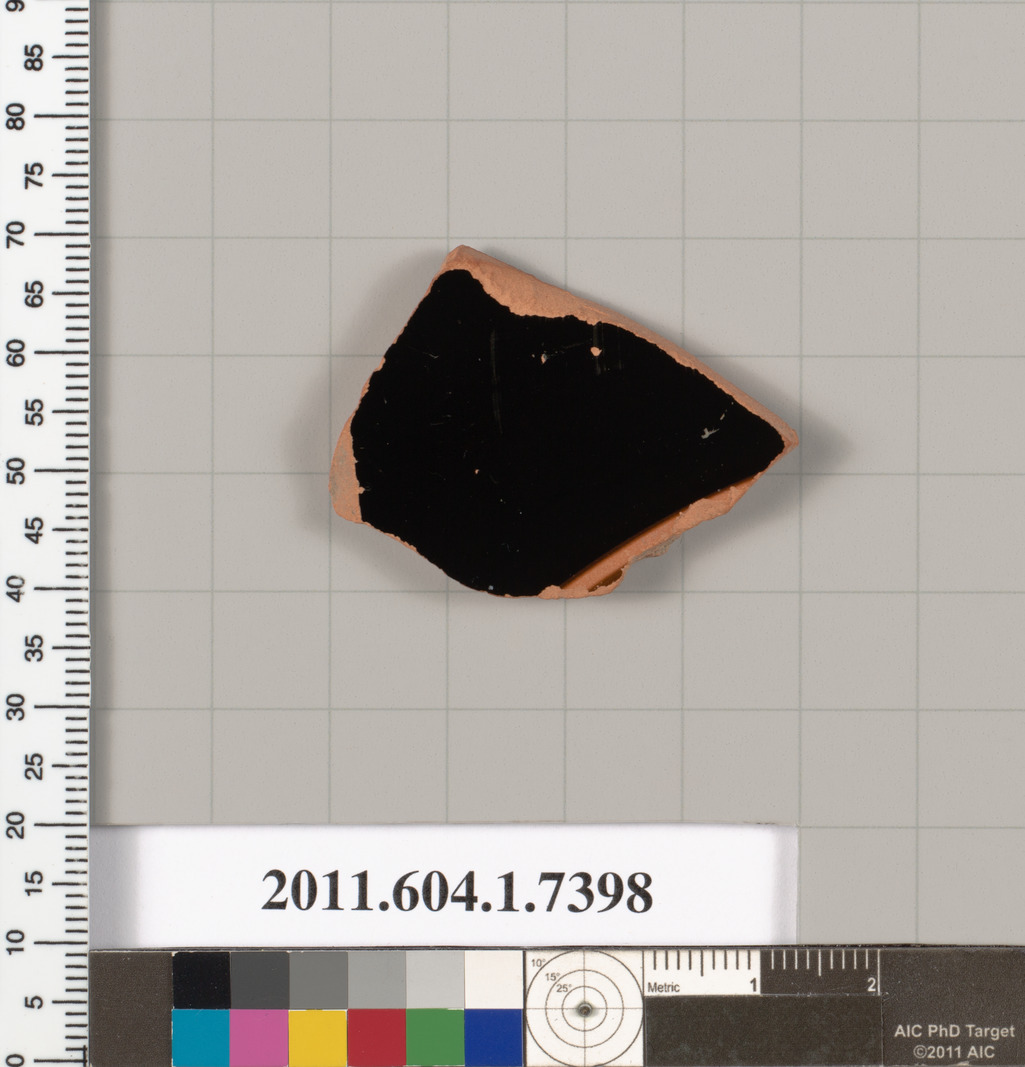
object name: kylix fragment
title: Terracotta fragment of a kylix (drinking cup)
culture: greek, attic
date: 500-480 BCE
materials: terracotta